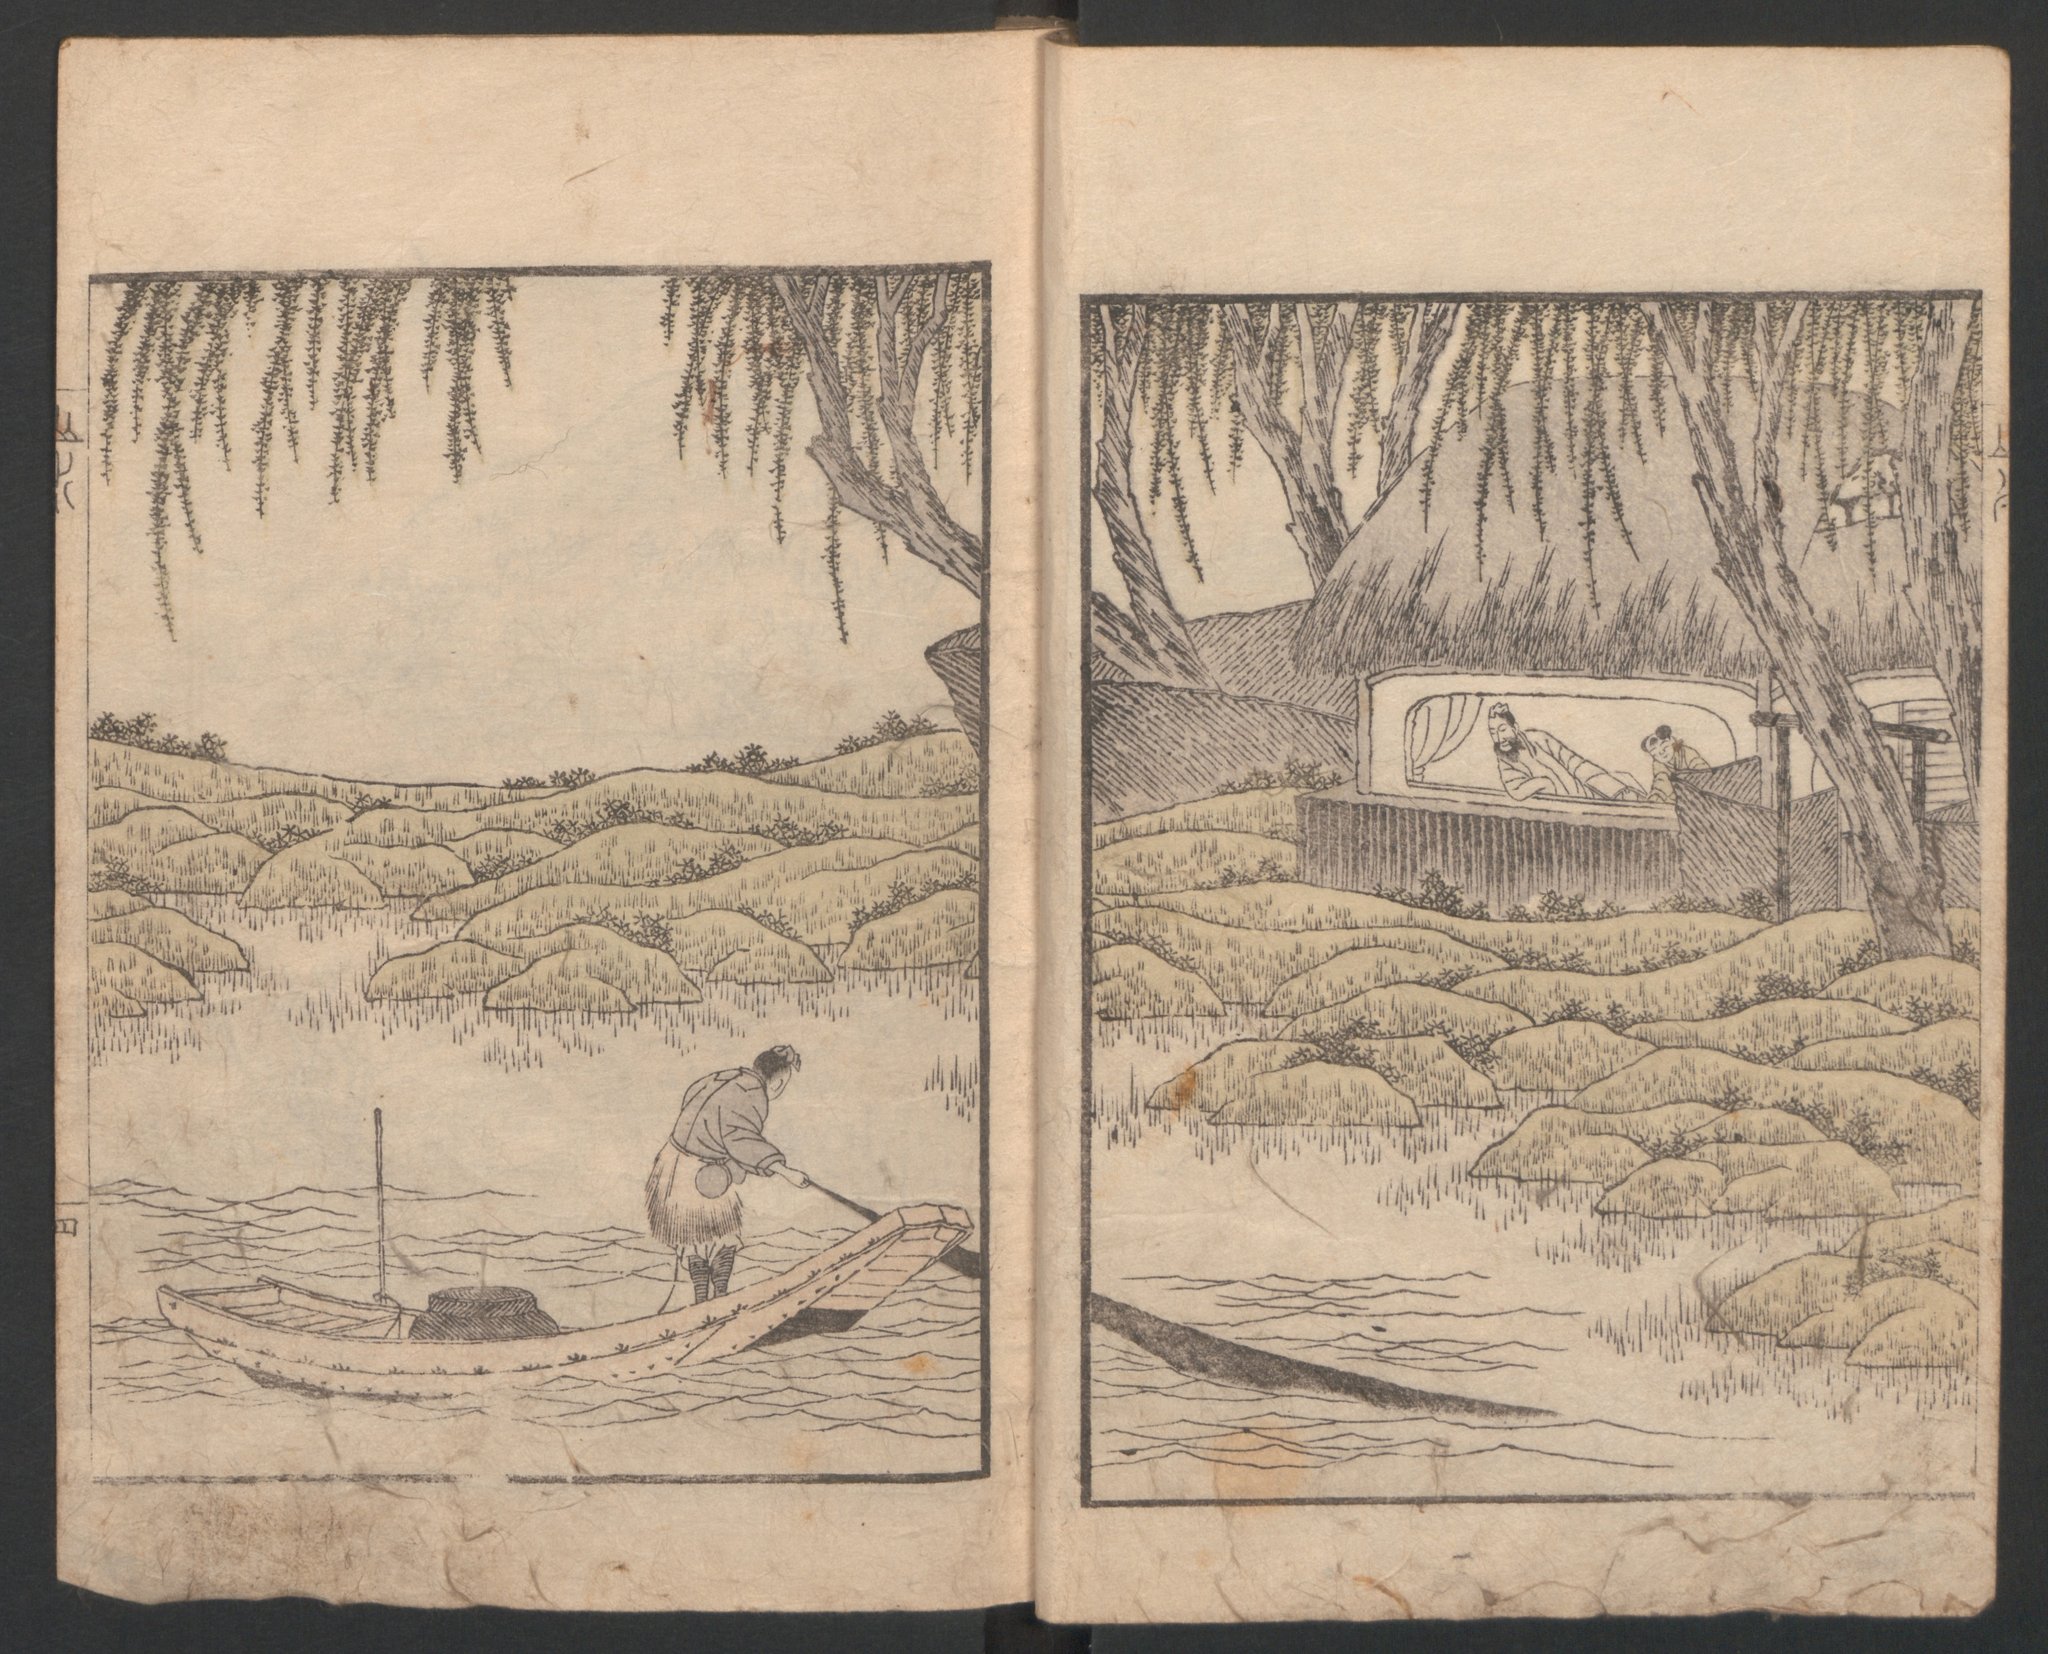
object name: illustrated book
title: Album of Landscape Paintings by Ichiro Yashima (Ichirō gafu) 一老画譜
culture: japanese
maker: yashima gakutei 八島岳亭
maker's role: artist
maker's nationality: japanese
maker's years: 1786-1868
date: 1823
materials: ink, paper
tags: men,women,landscapes,boats,eating